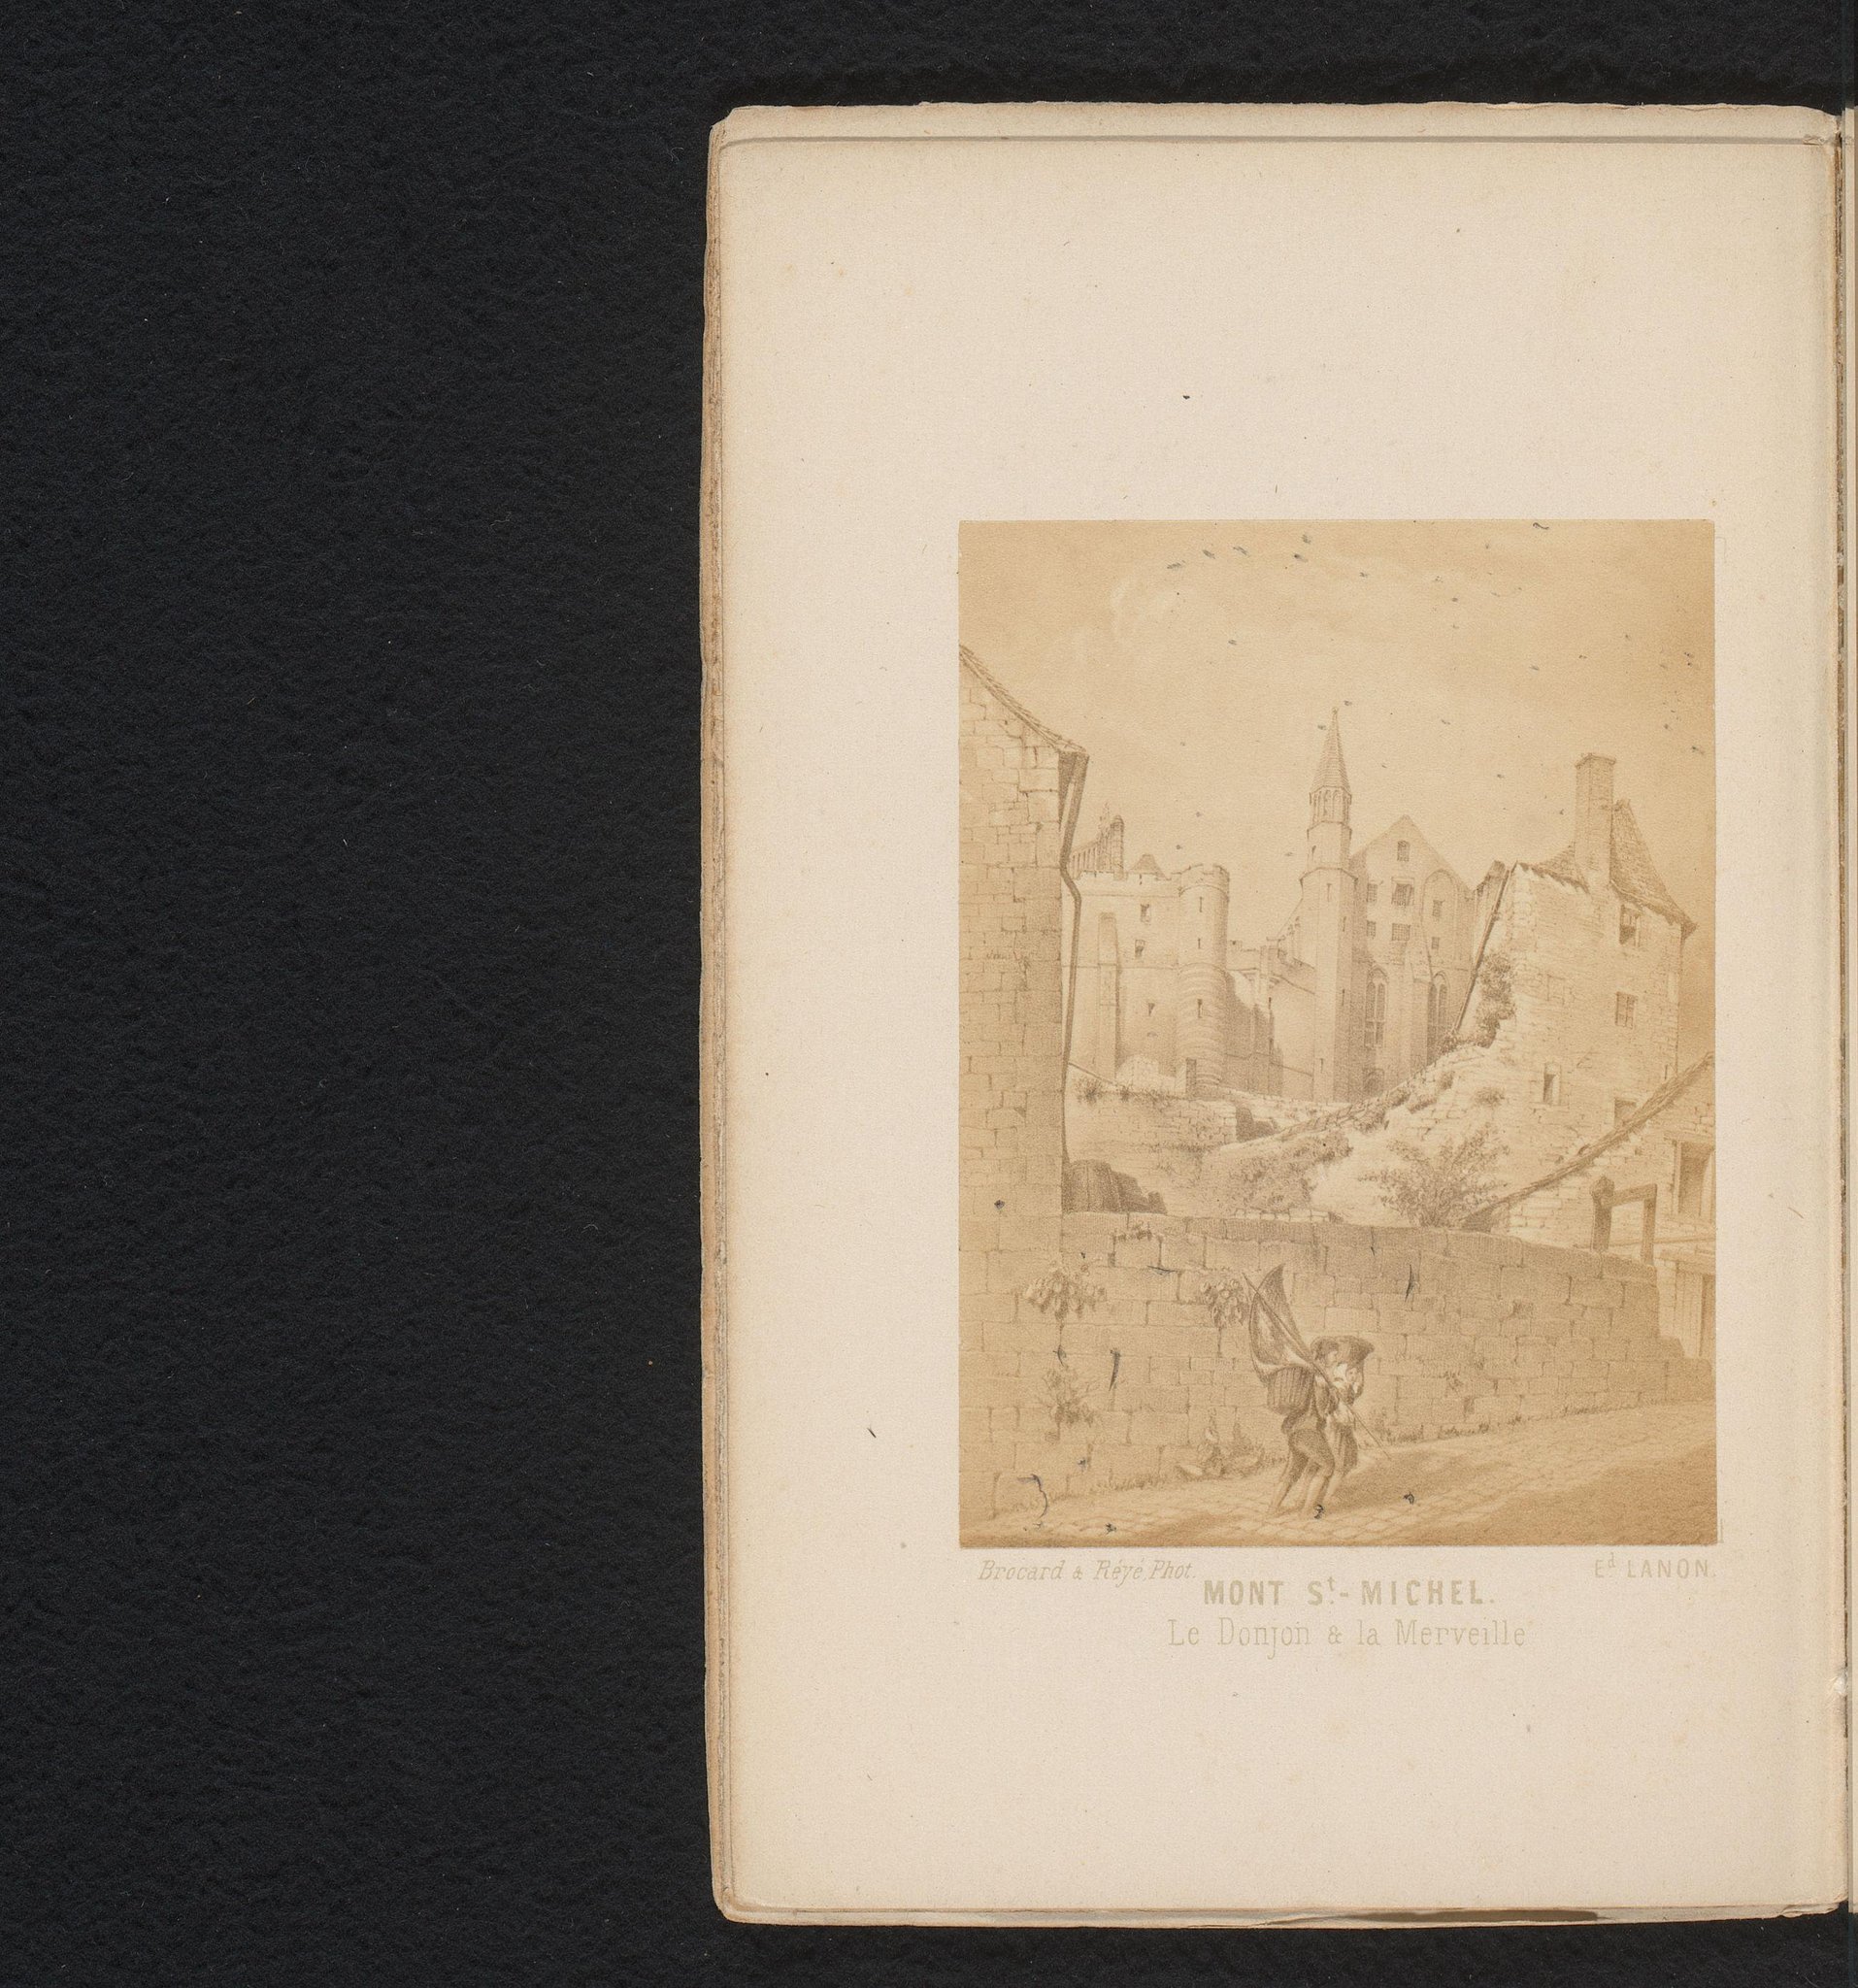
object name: page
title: Mont St.-Michel. Le Donjon & la Merveille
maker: edmond lanon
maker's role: designer, draughtsman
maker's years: 1830-1871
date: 1861-1866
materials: paper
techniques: albumen print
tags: towers ~ fortified city, abbey, monastery, convent ~ roman catholic church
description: Foto op ongenummerde pagina tegenover pagina 17.